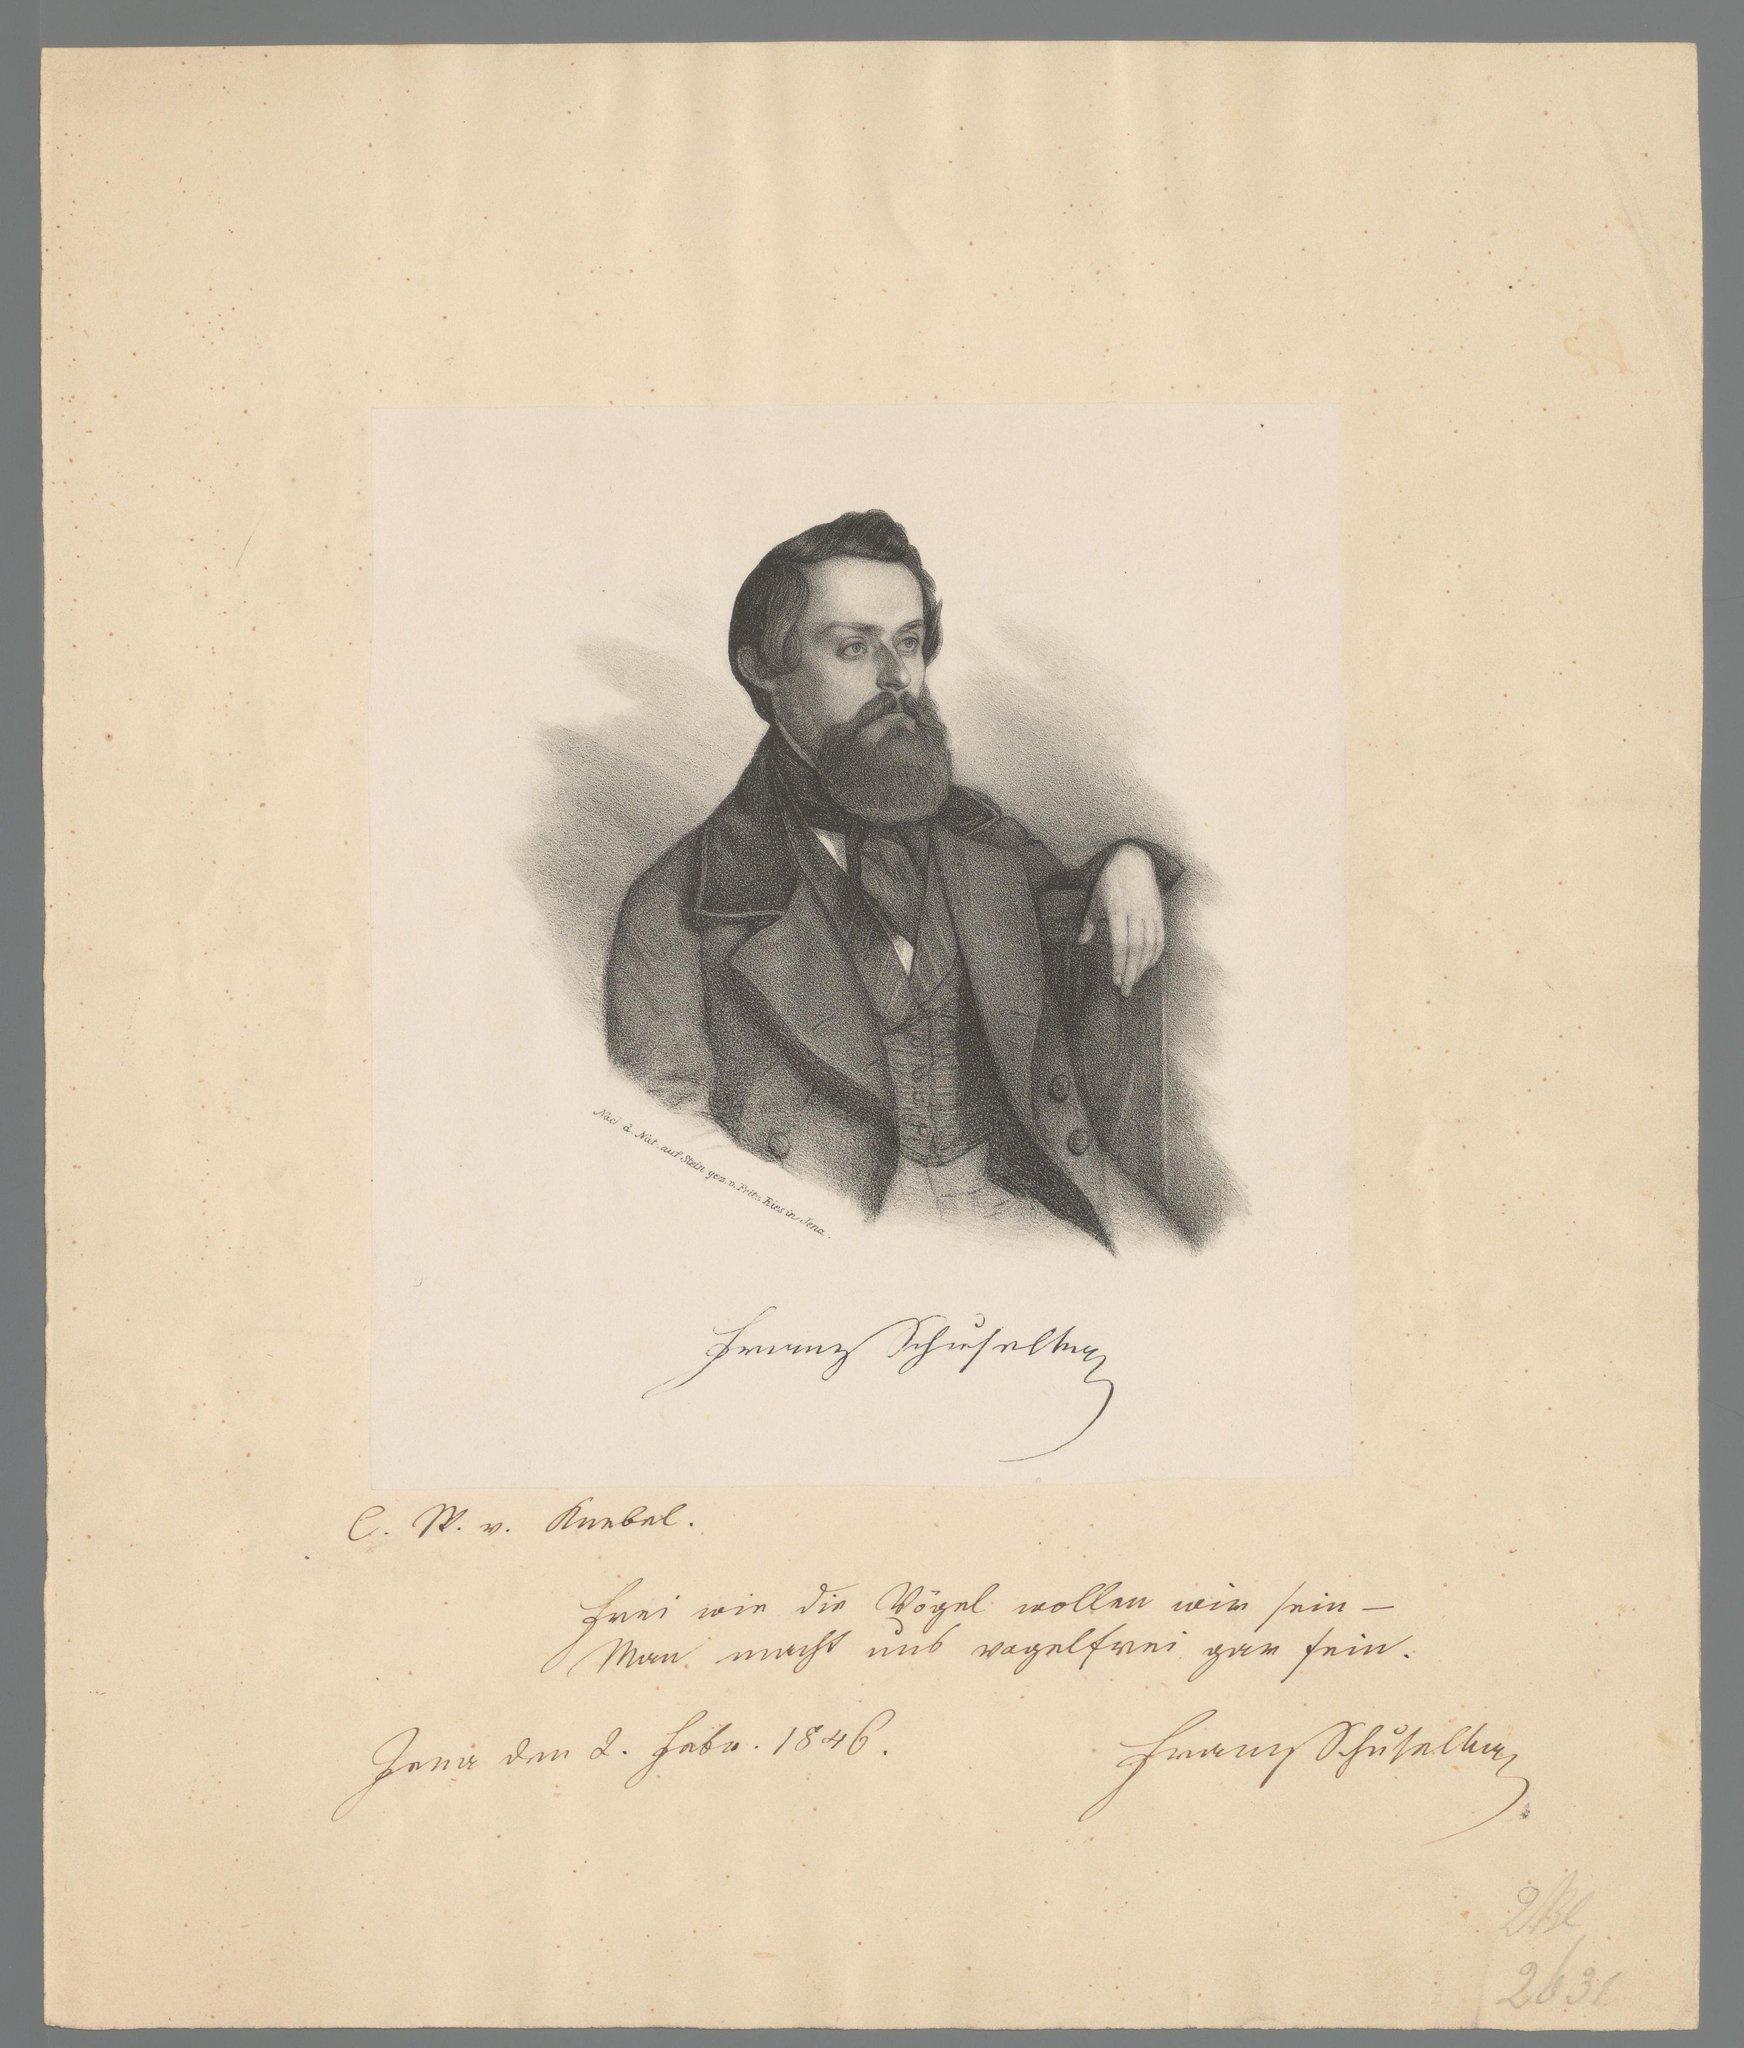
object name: print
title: Portret van Franz Schuselka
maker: fritz ries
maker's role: print maker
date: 1826-1857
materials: paper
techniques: lithograph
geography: jena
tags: politician, historical persons, politician, e.g. party leader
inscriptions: collector's mark: Lugt 2228